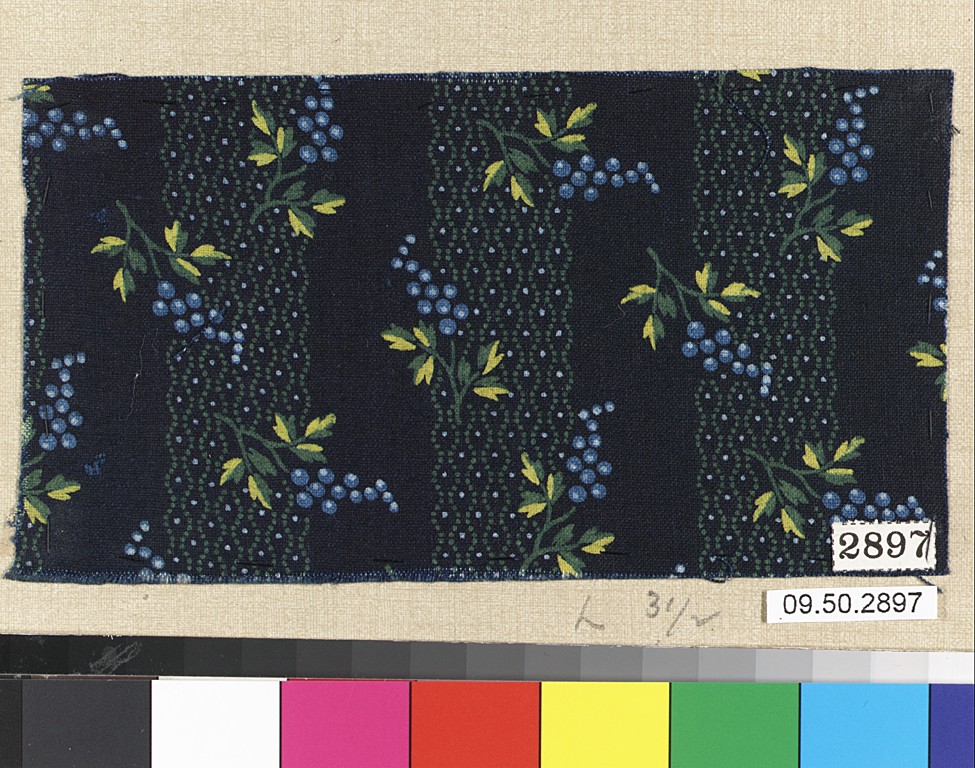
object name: piece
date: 1801-1900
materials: cotton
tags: grapes,leaves